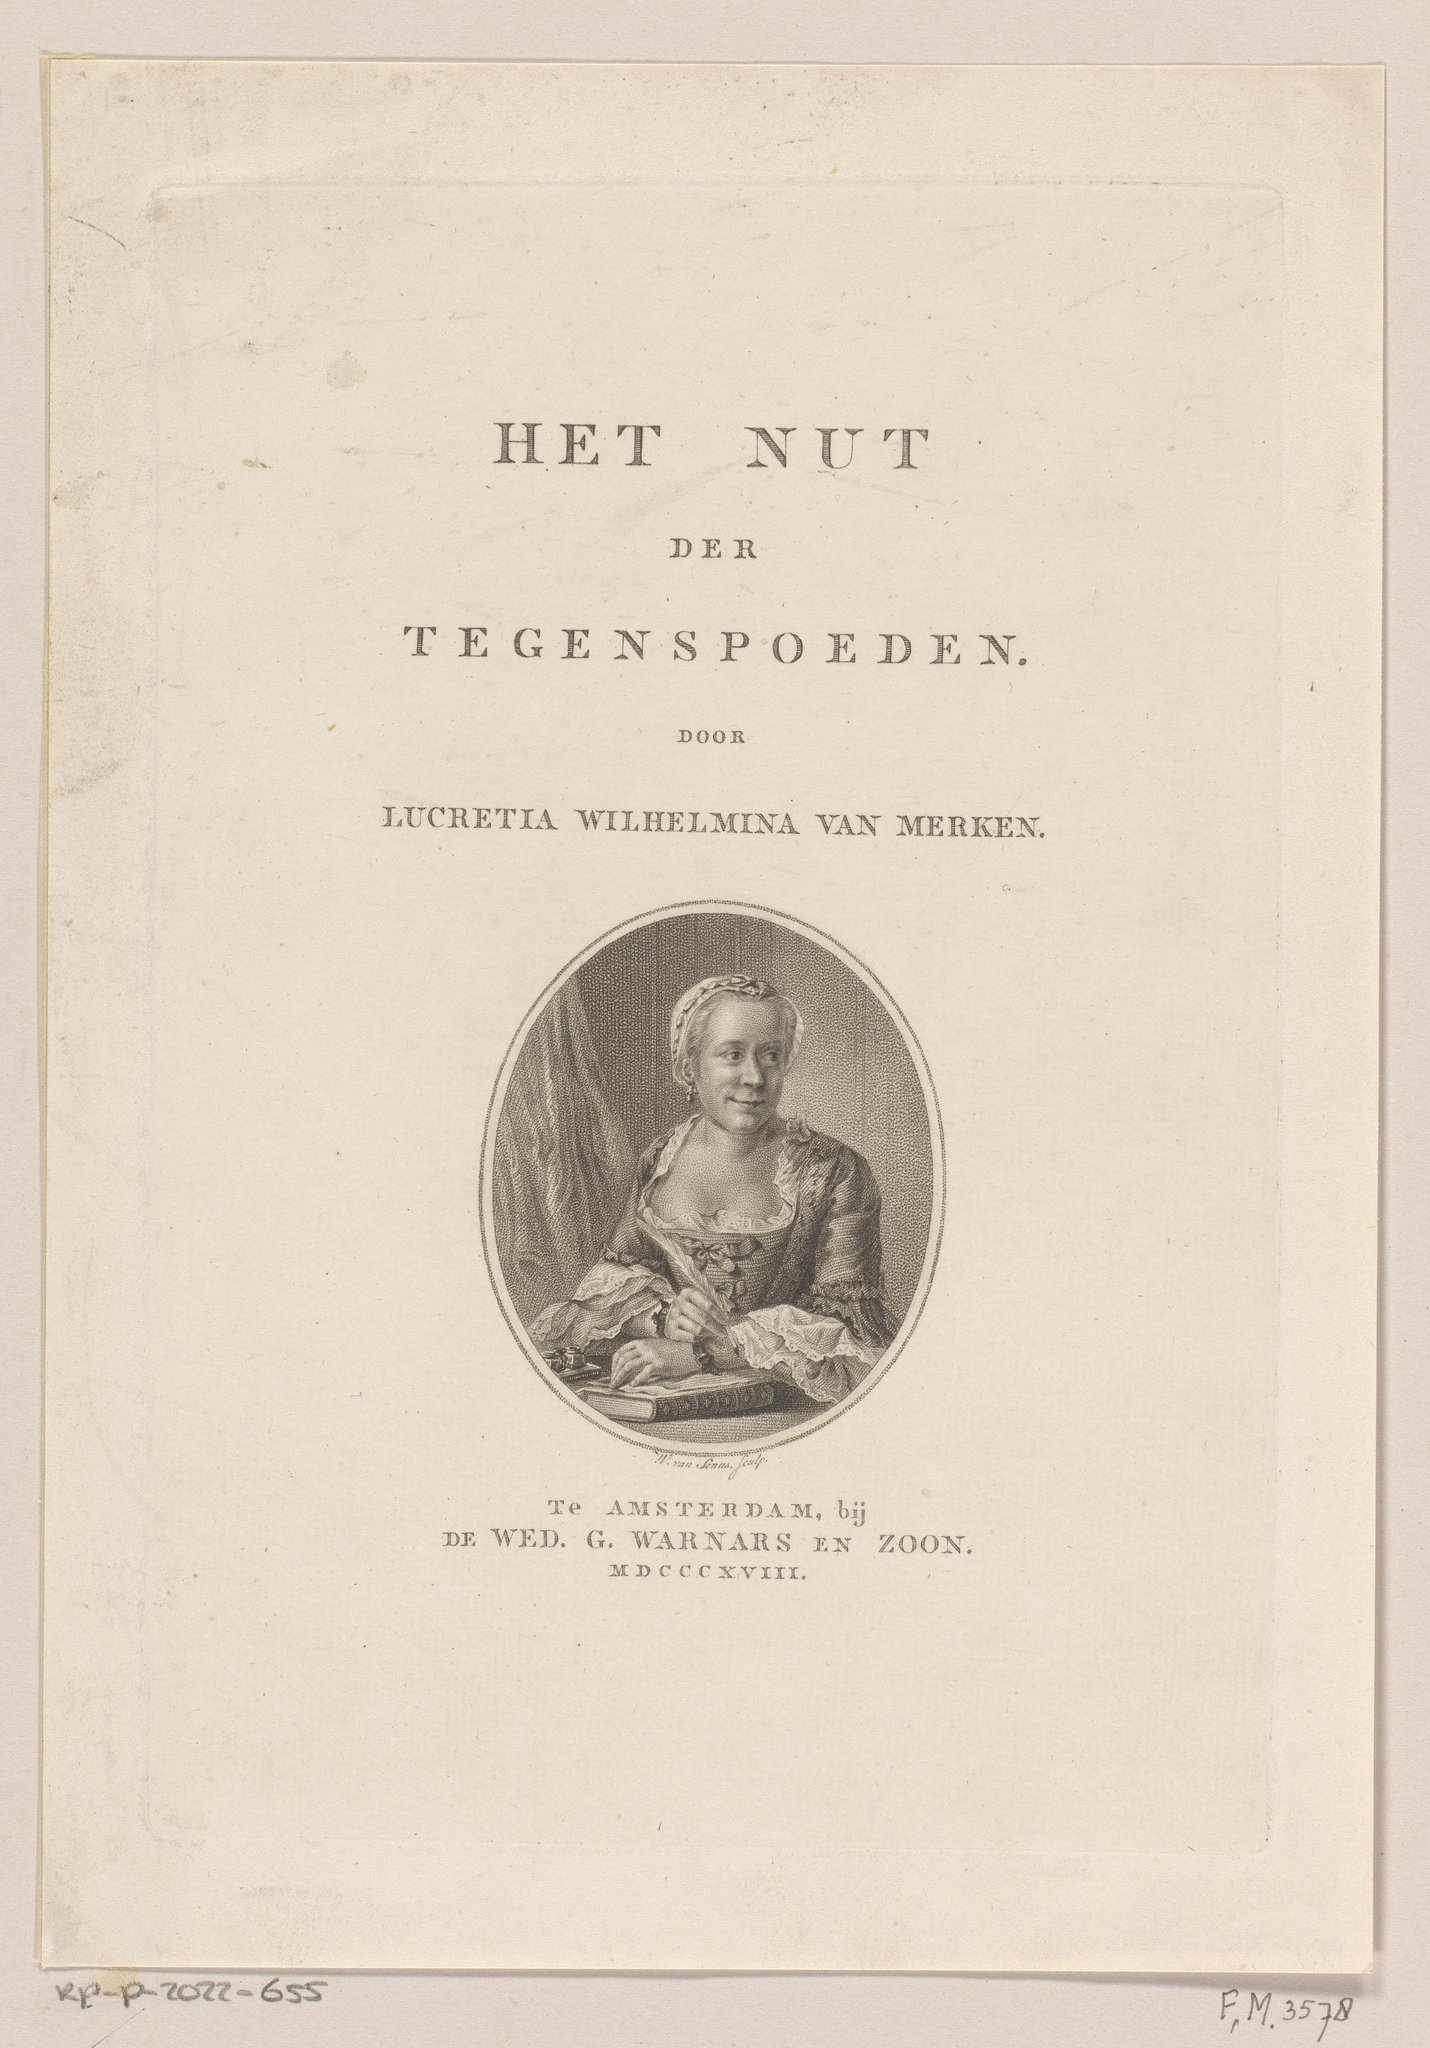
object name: titelblad, titelpagina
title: Titelpagina voor: Merken, Lucretia Wilhelmina van. Het nut der tegenspoeden, 1818.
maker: willem van senus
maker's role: painter, print maker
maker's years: 1773-1851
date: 1818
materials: paper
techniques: etching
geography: amsterdam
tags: amsterdam, leiden, lucretia wilhelmina van merken, historical persons - bb - woman, portrait of a writer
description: Titelpagina voor: Merken, Lucretia Wilhelmina van. Het nut der tegenspoeden. Amsterdam: weduwe Gerrit Warnars & zoon, 1818.